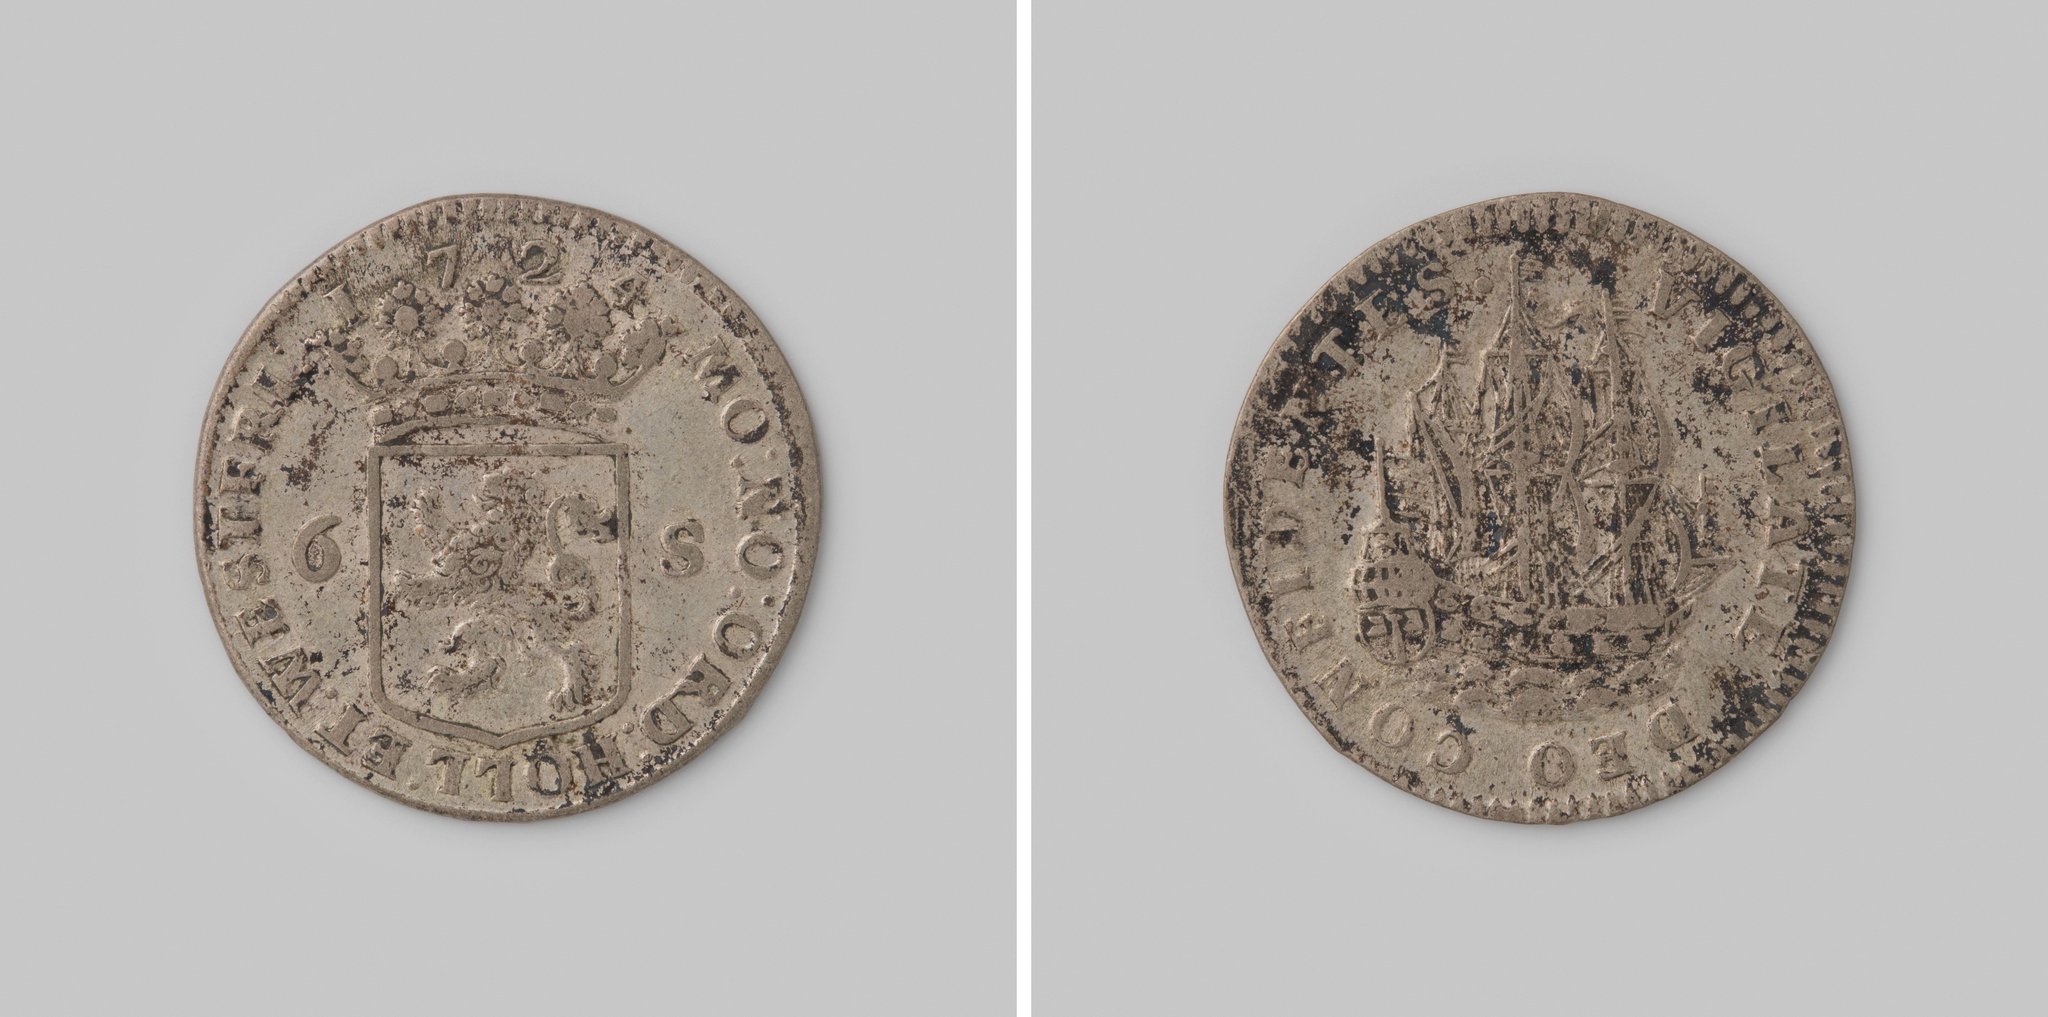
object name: coin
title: Holland, scheeepjesschelling, 1724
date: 1724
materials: silver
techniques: striking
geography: dordrecht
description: Zilveren munt. Voorzijde: tussen waarde-aanduiding 6 S gekroond wapenschild van Holland. Jaartal boven kroon. Keerzijde: oorlogsschip, varend naar rechts.